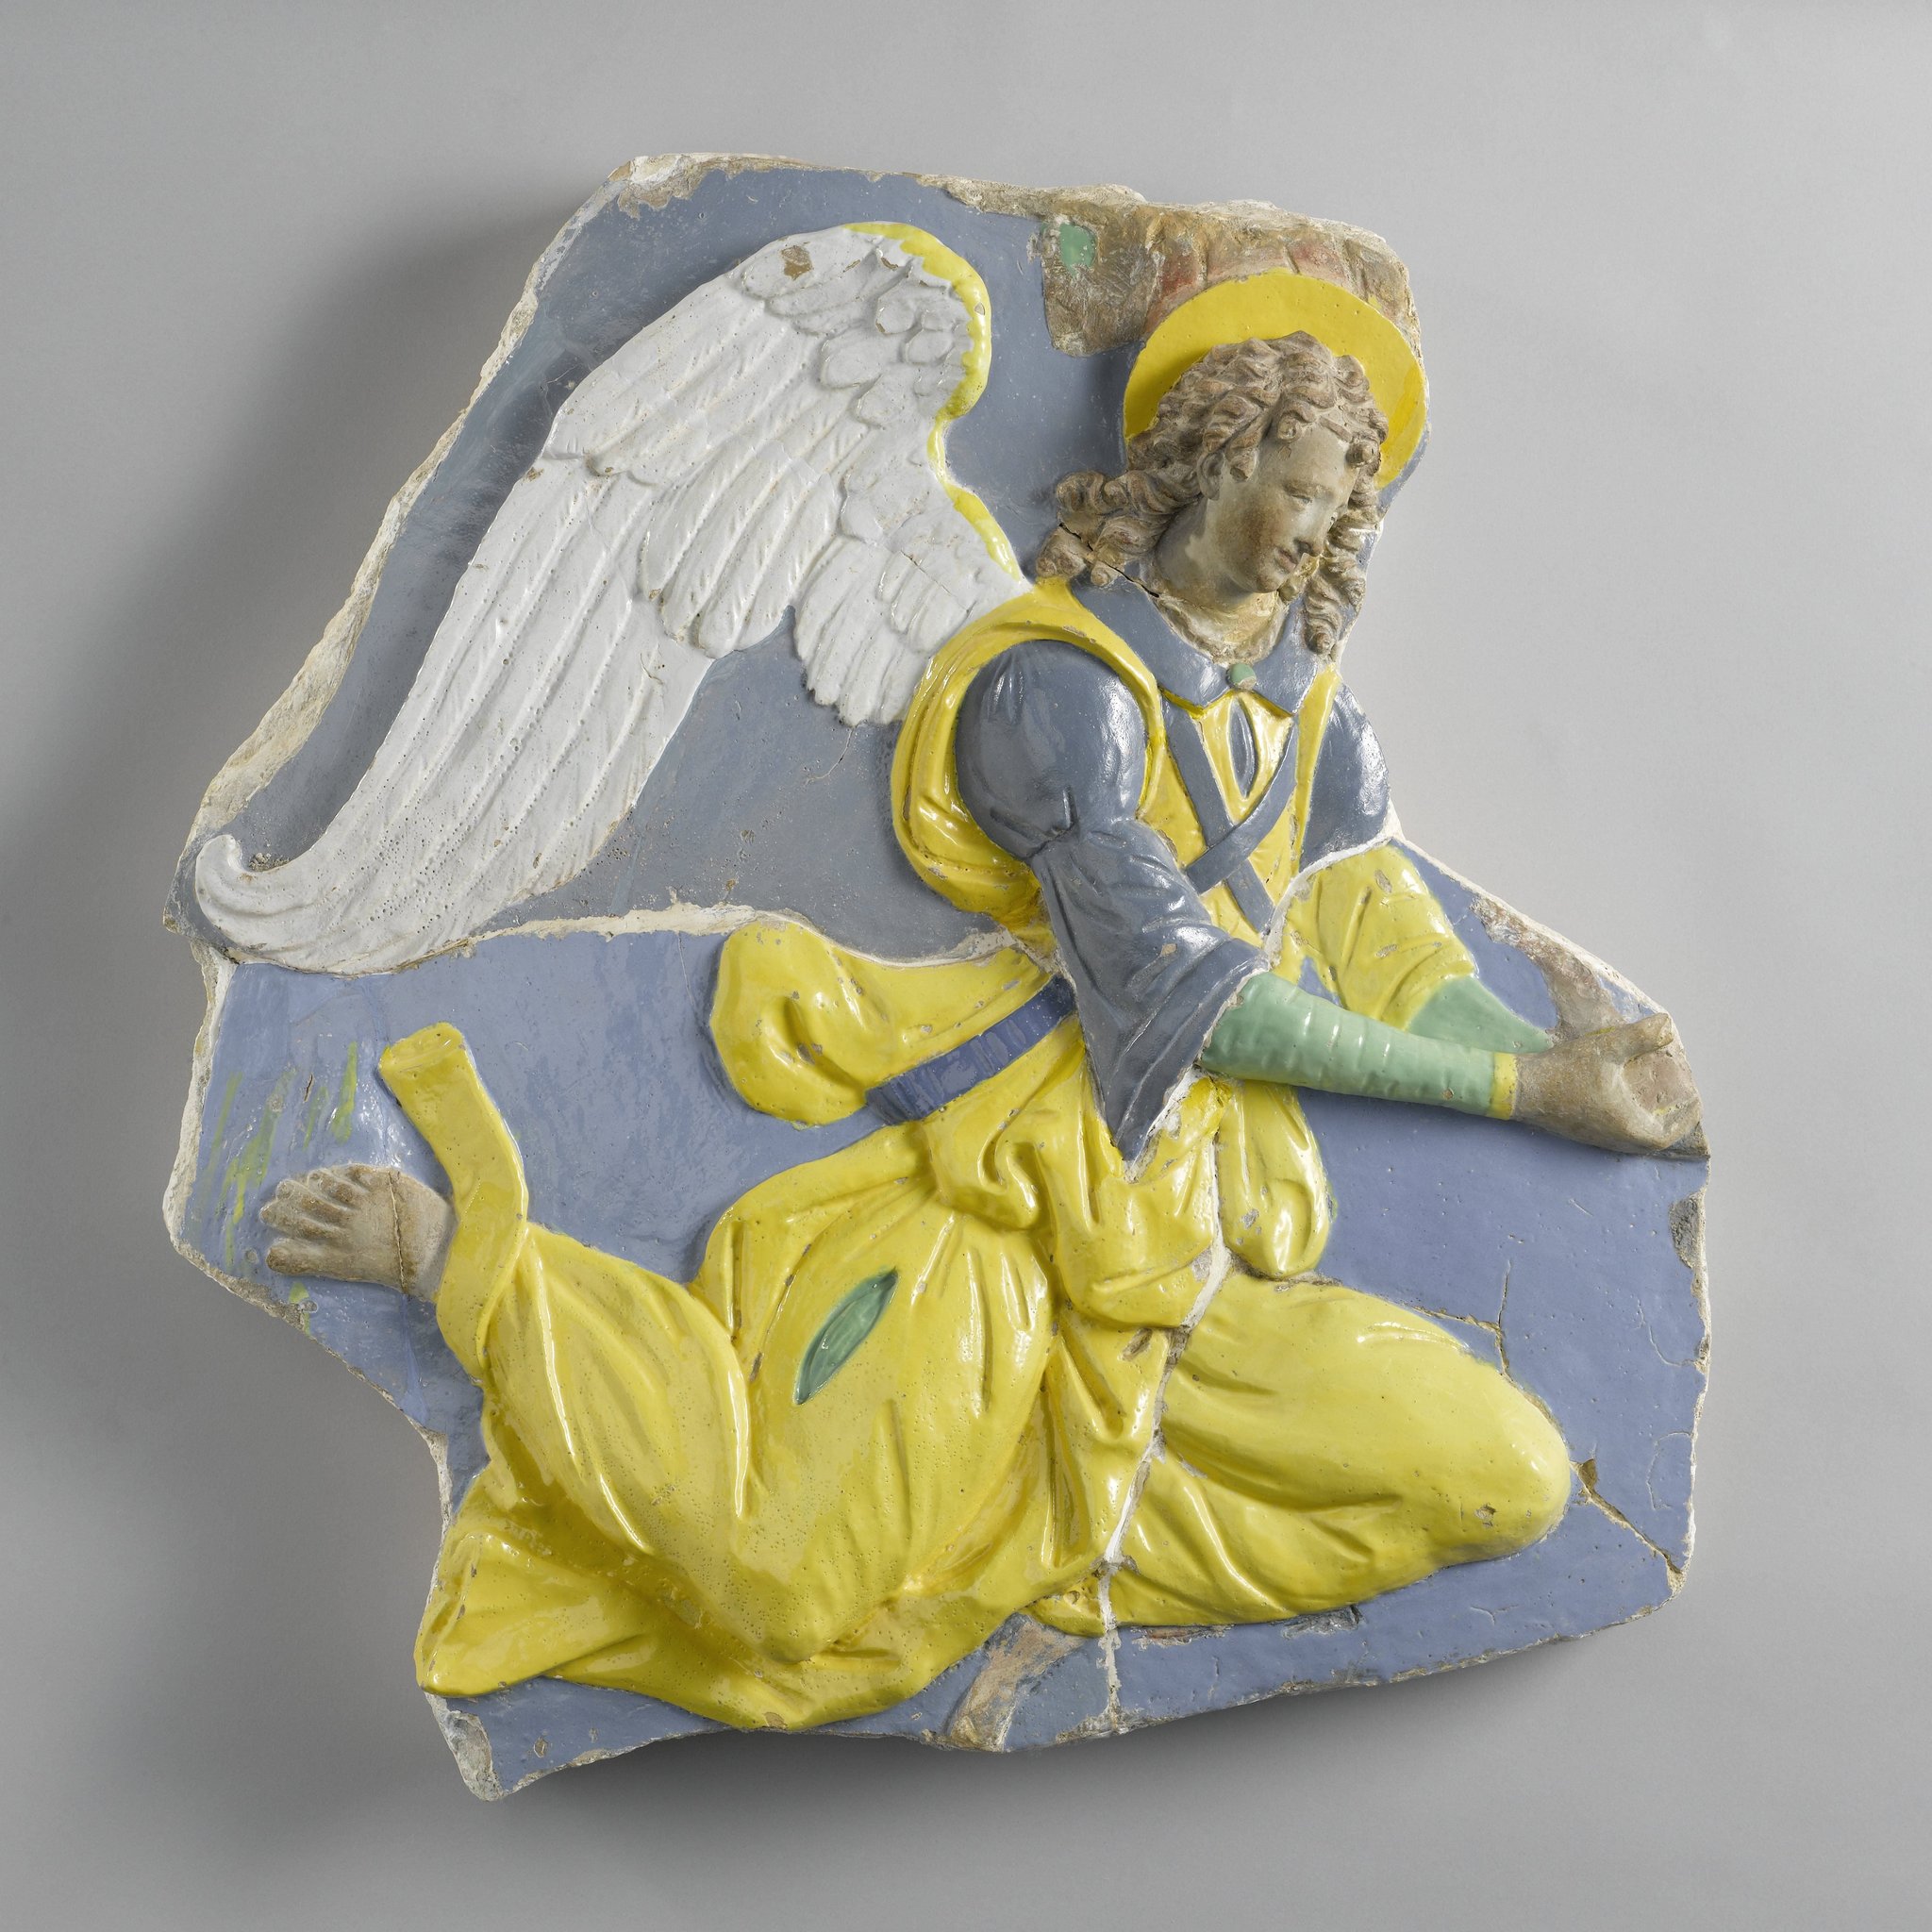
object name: relief sculpture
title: Zwevende engel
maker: luca della robbia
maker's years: 1400-1482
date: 1500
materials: earthenware, glaze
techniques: maiolica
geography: florence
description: Workshop of Luca della Robbia (1399 - 1482). Two hovering angels. Maiolica. Florence, c. 1500.